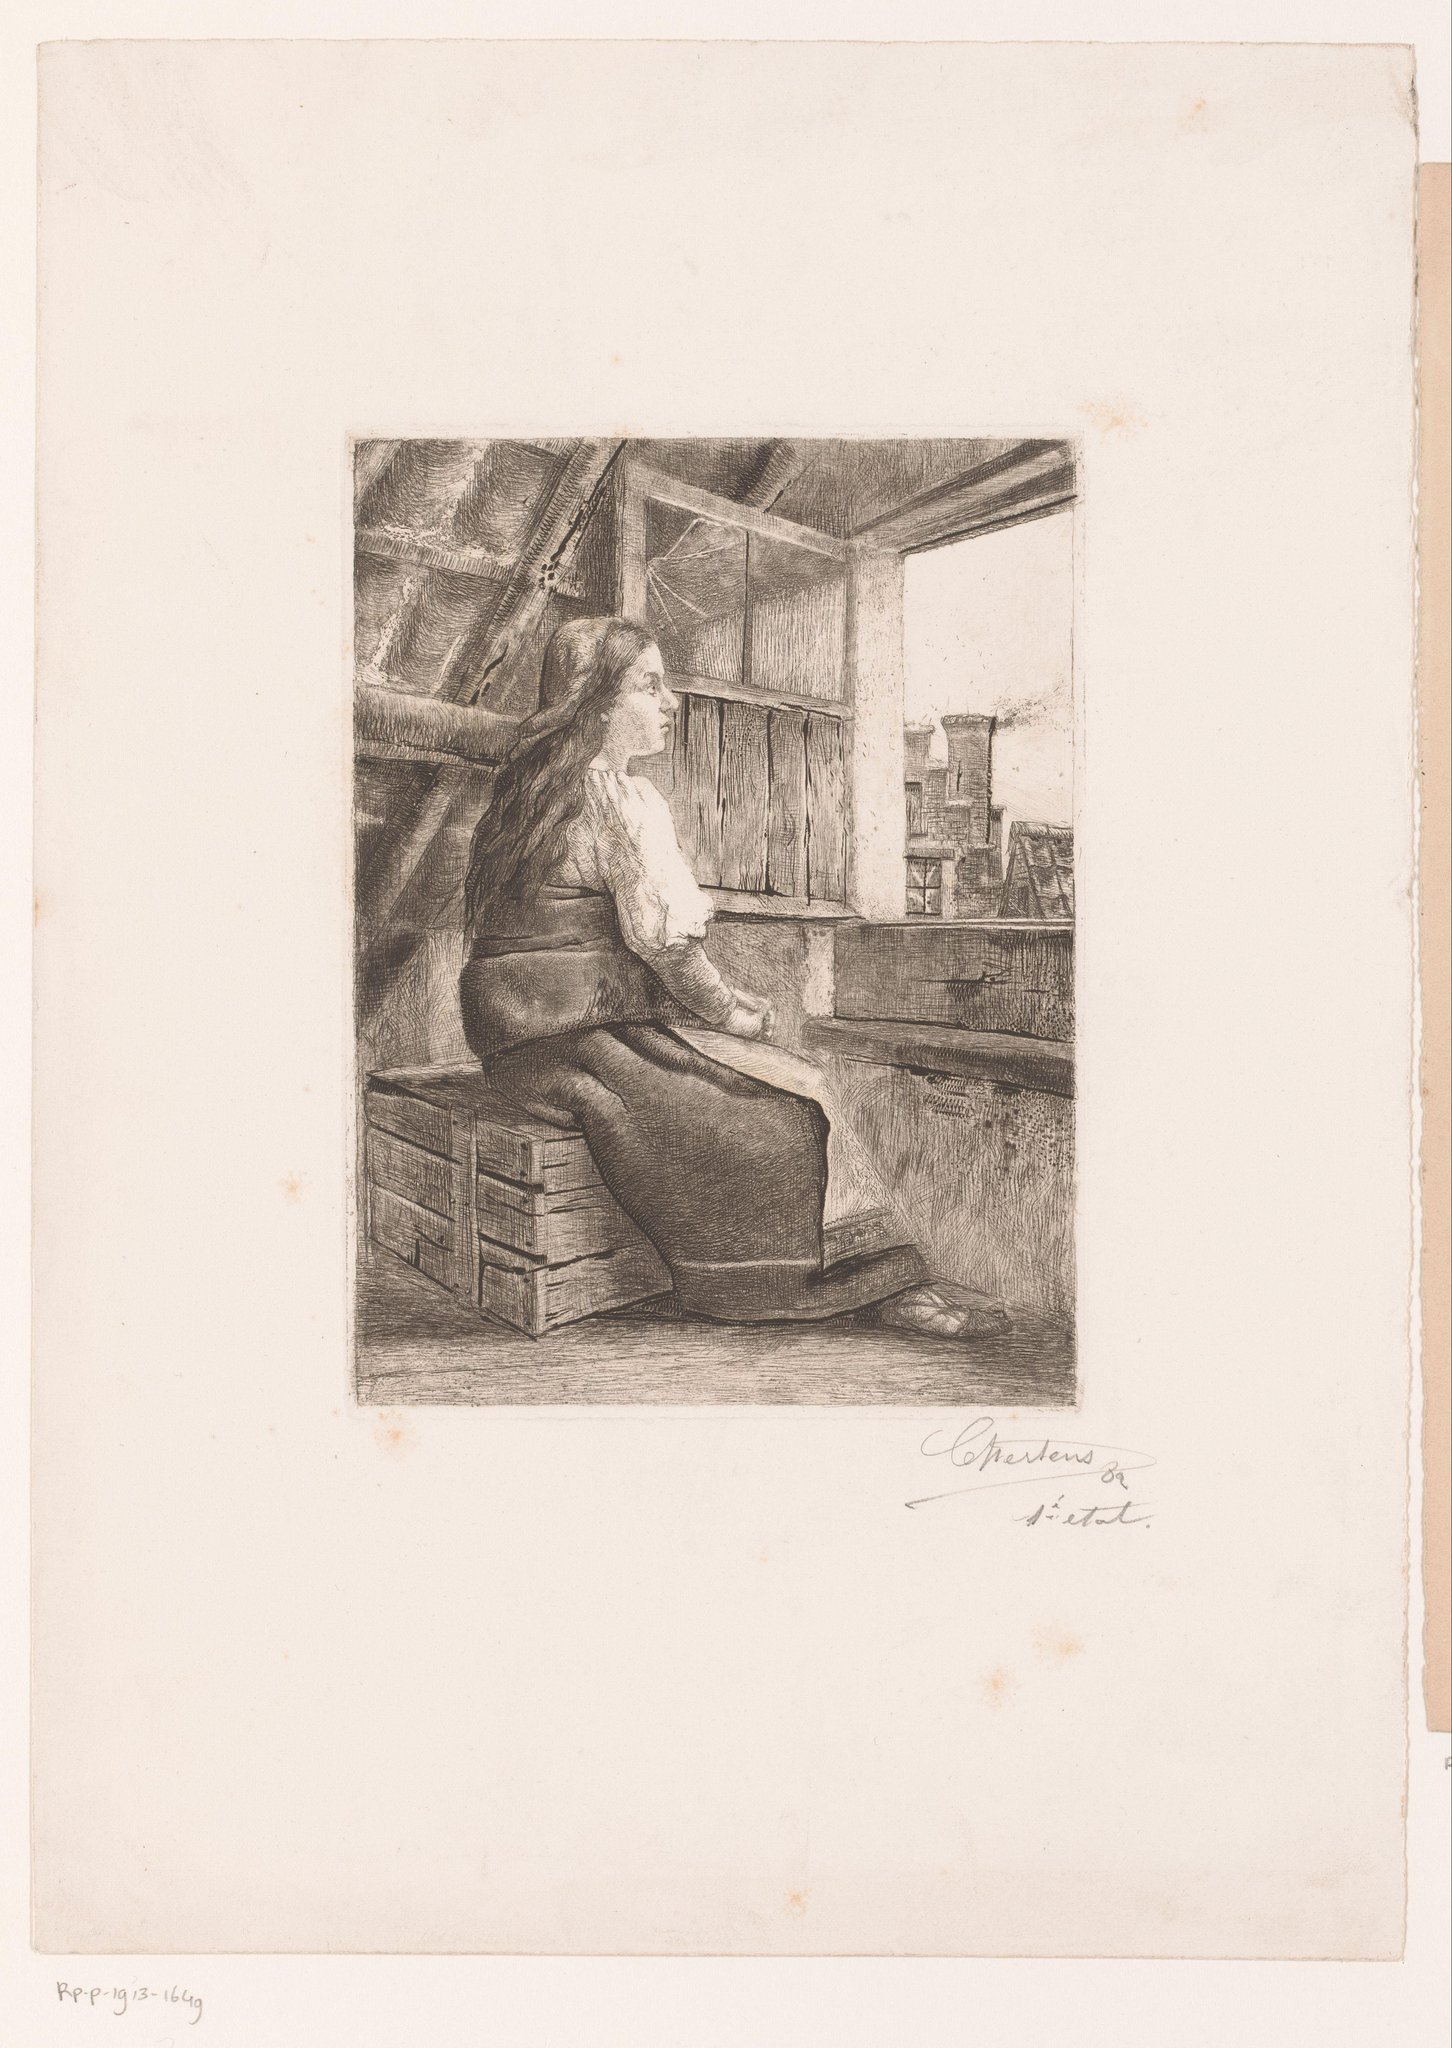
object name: print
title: Meisje kijkt via een dakvenster naar buiten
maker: charles mertens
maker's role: print maker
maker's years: 1865-1919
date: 1882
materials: paper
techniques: drypoint, etching, intaglio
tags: girl (child between toddler and youth), human figure at (open) window, seen from inside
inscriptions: inscription: ‘1e etat’, collector's mark: Lugt 2228